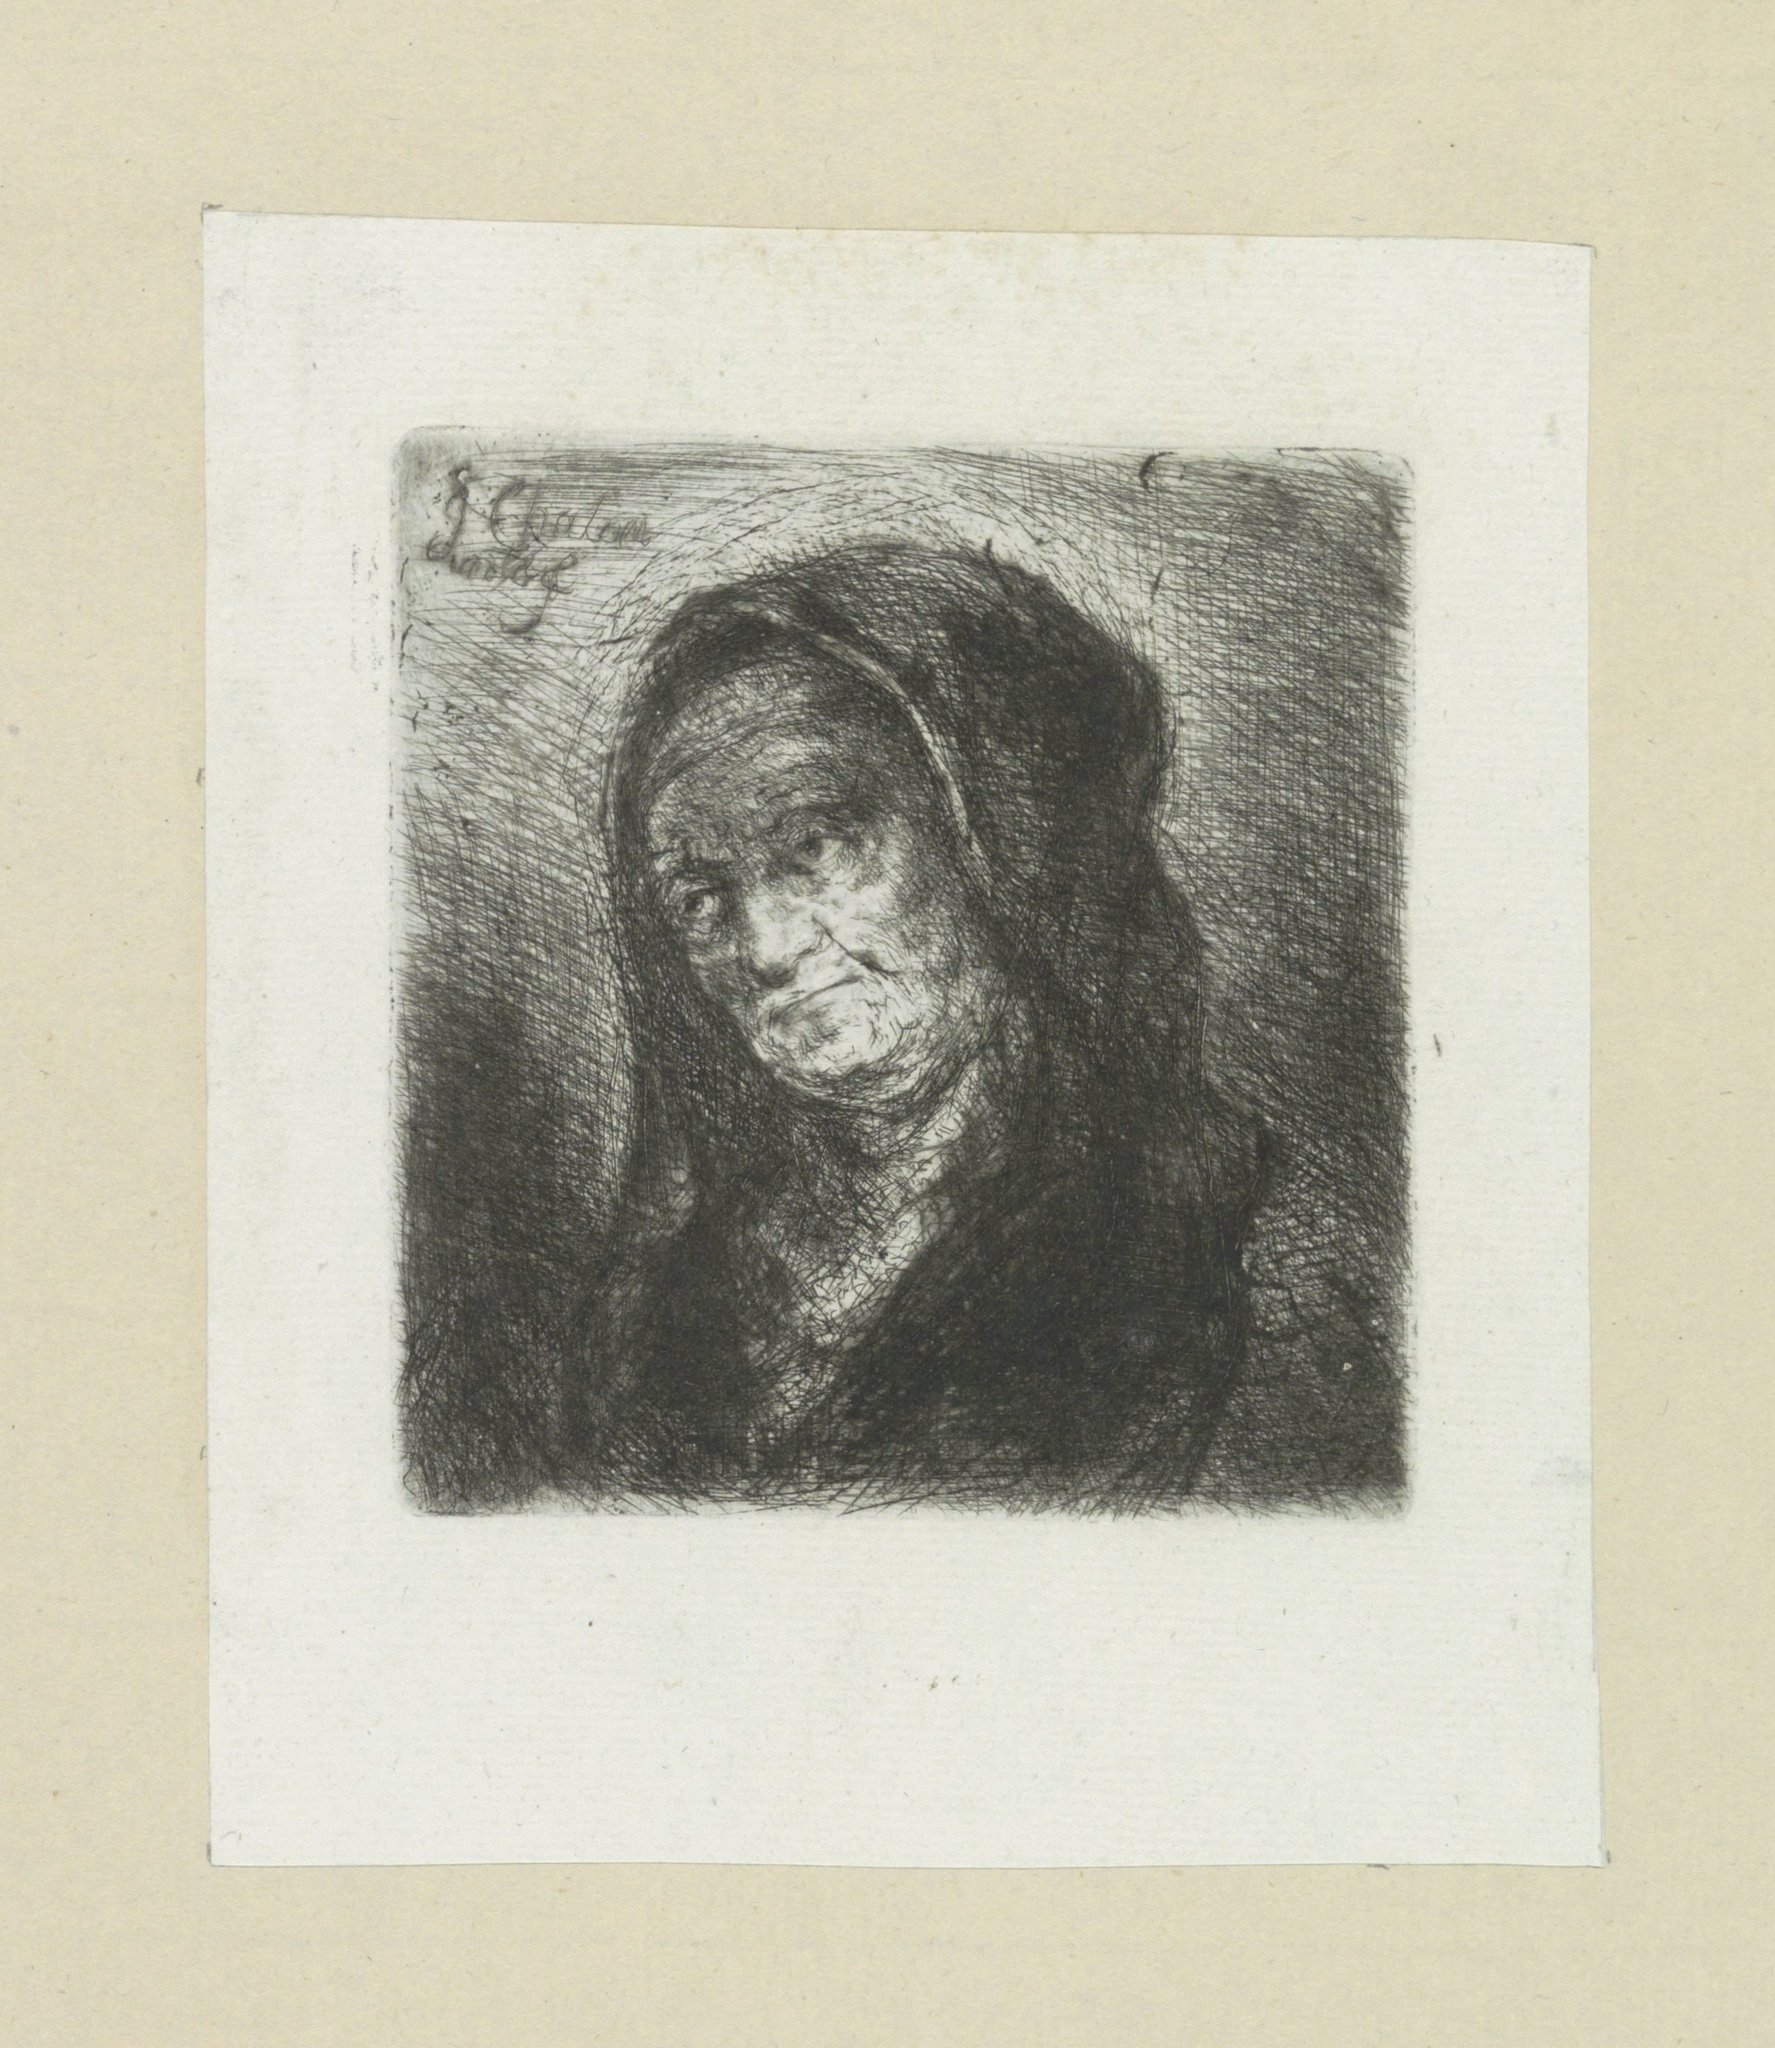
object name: album leaf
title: The Compleat Work of Etchings by John Chalon / Oeuvre Complette des Eaux Fortes par Jean Chalon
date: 1802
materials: paper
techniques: drypoint, etching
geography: amsterdam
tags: veil, morphology of human expression (+ old female (human being))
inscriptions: collector's mark: ‘RIJKS / MUSM’, collector's mark: ‘B’